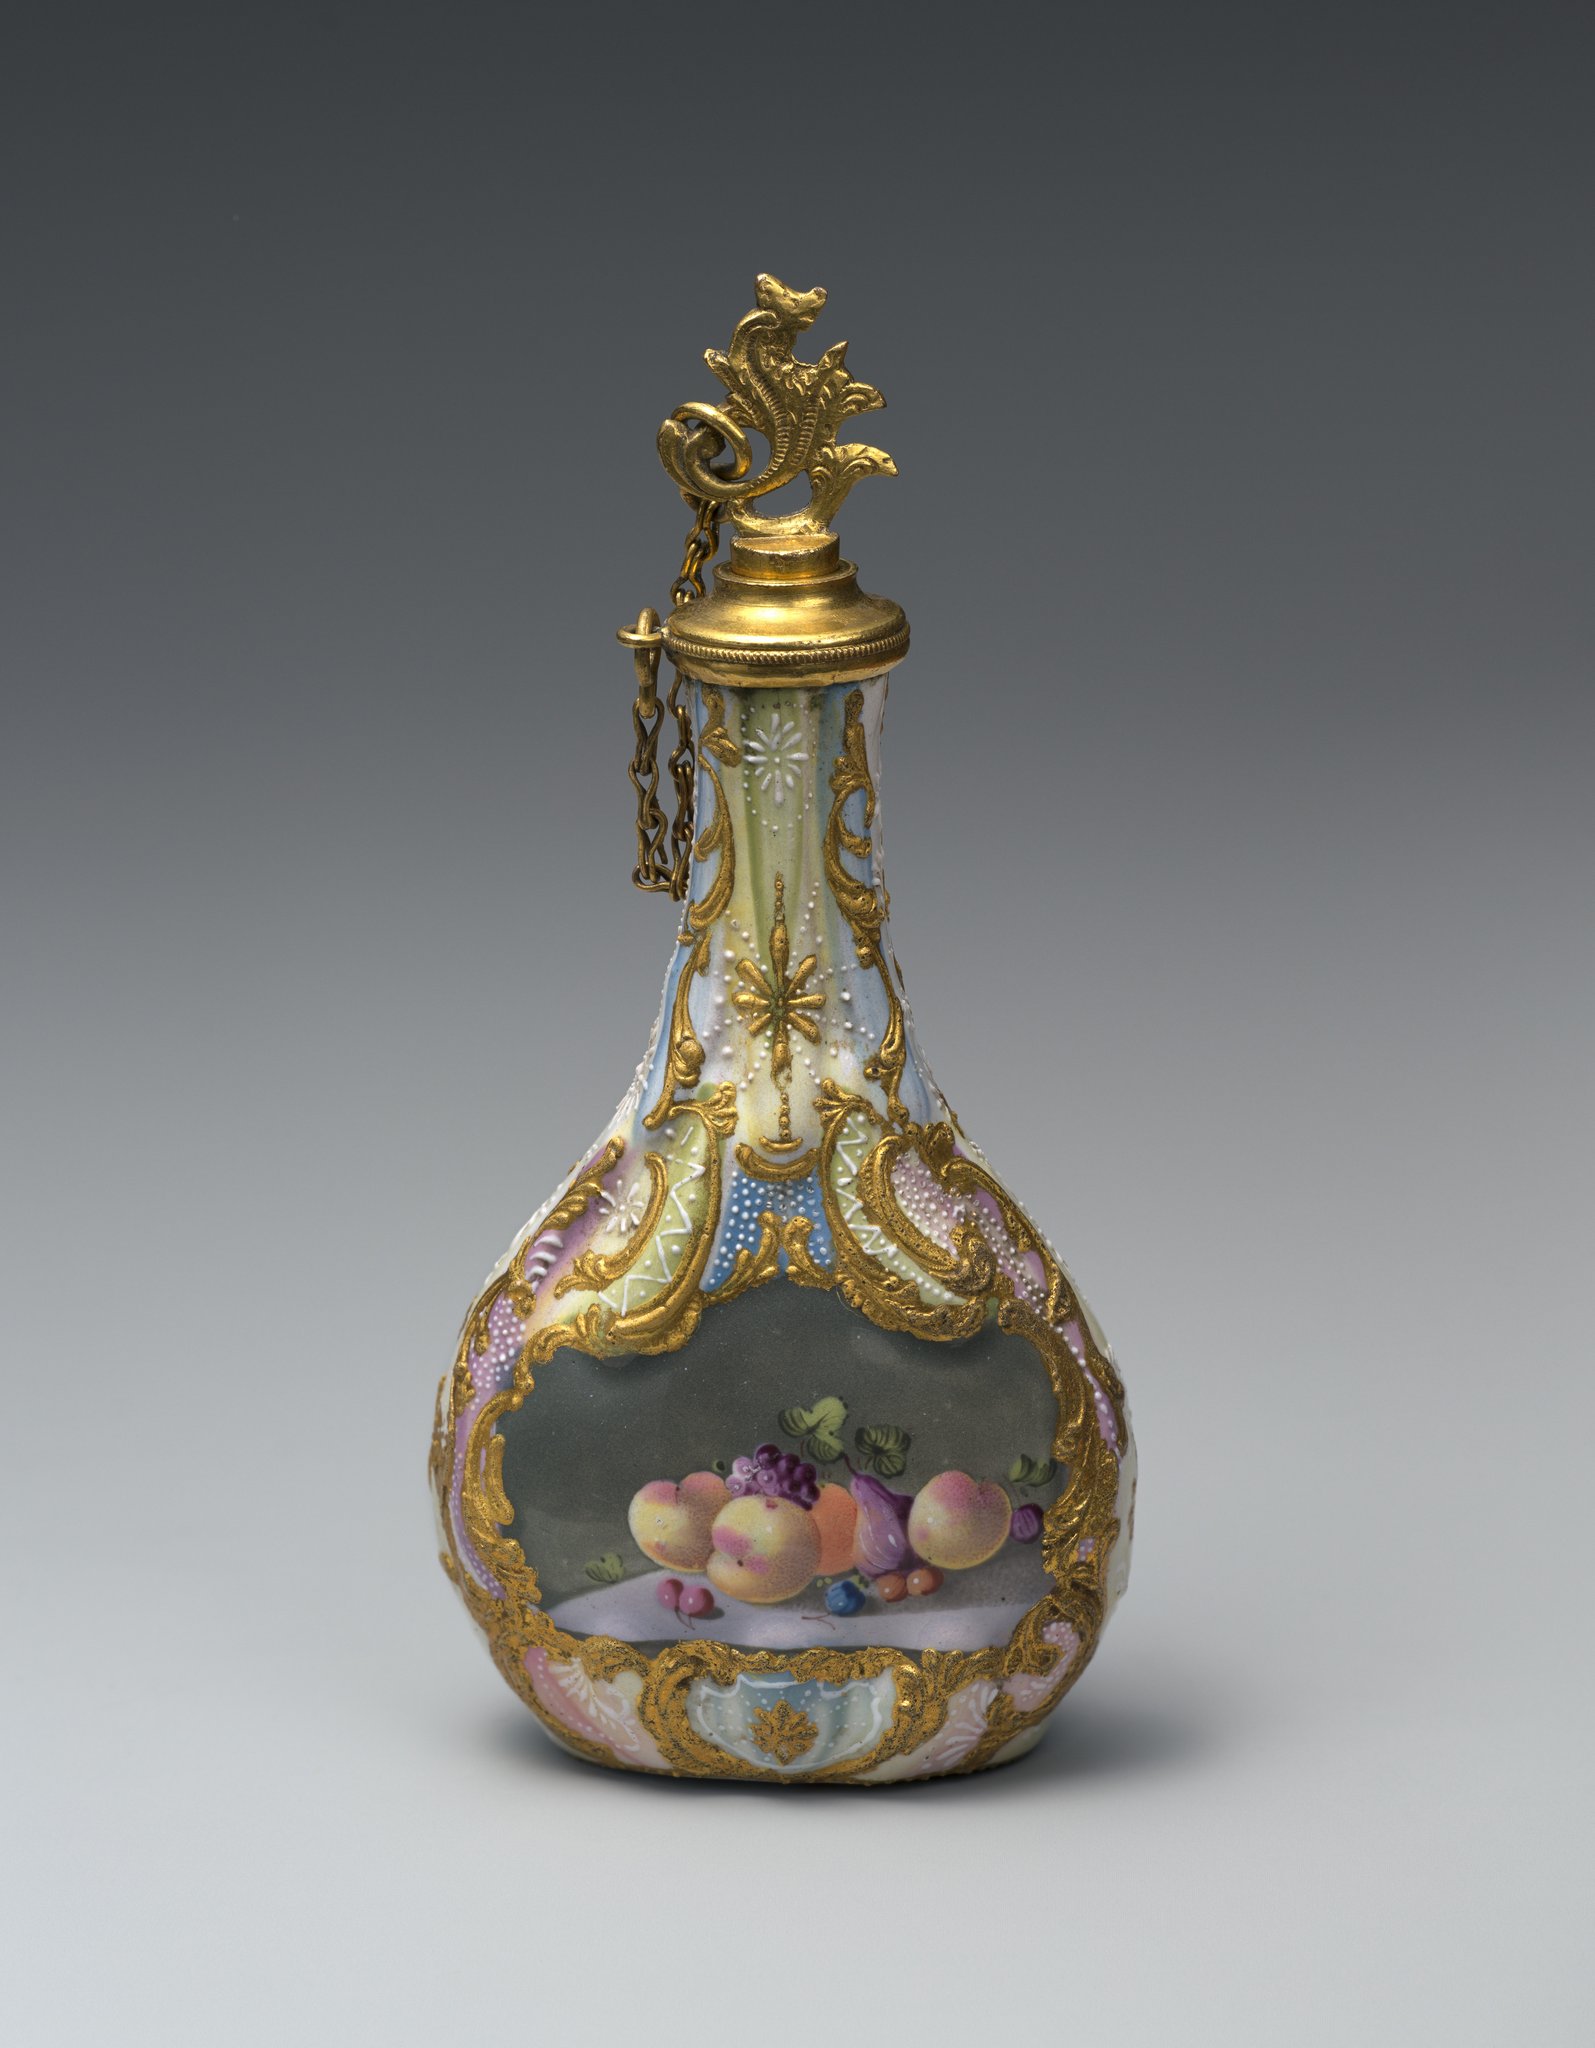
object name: scent bottle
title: Scent bottle with still life of fruit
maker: robert hancock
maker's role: engraver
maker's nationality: british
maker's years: 1730-1817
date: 1765-1770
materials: copper, enamel